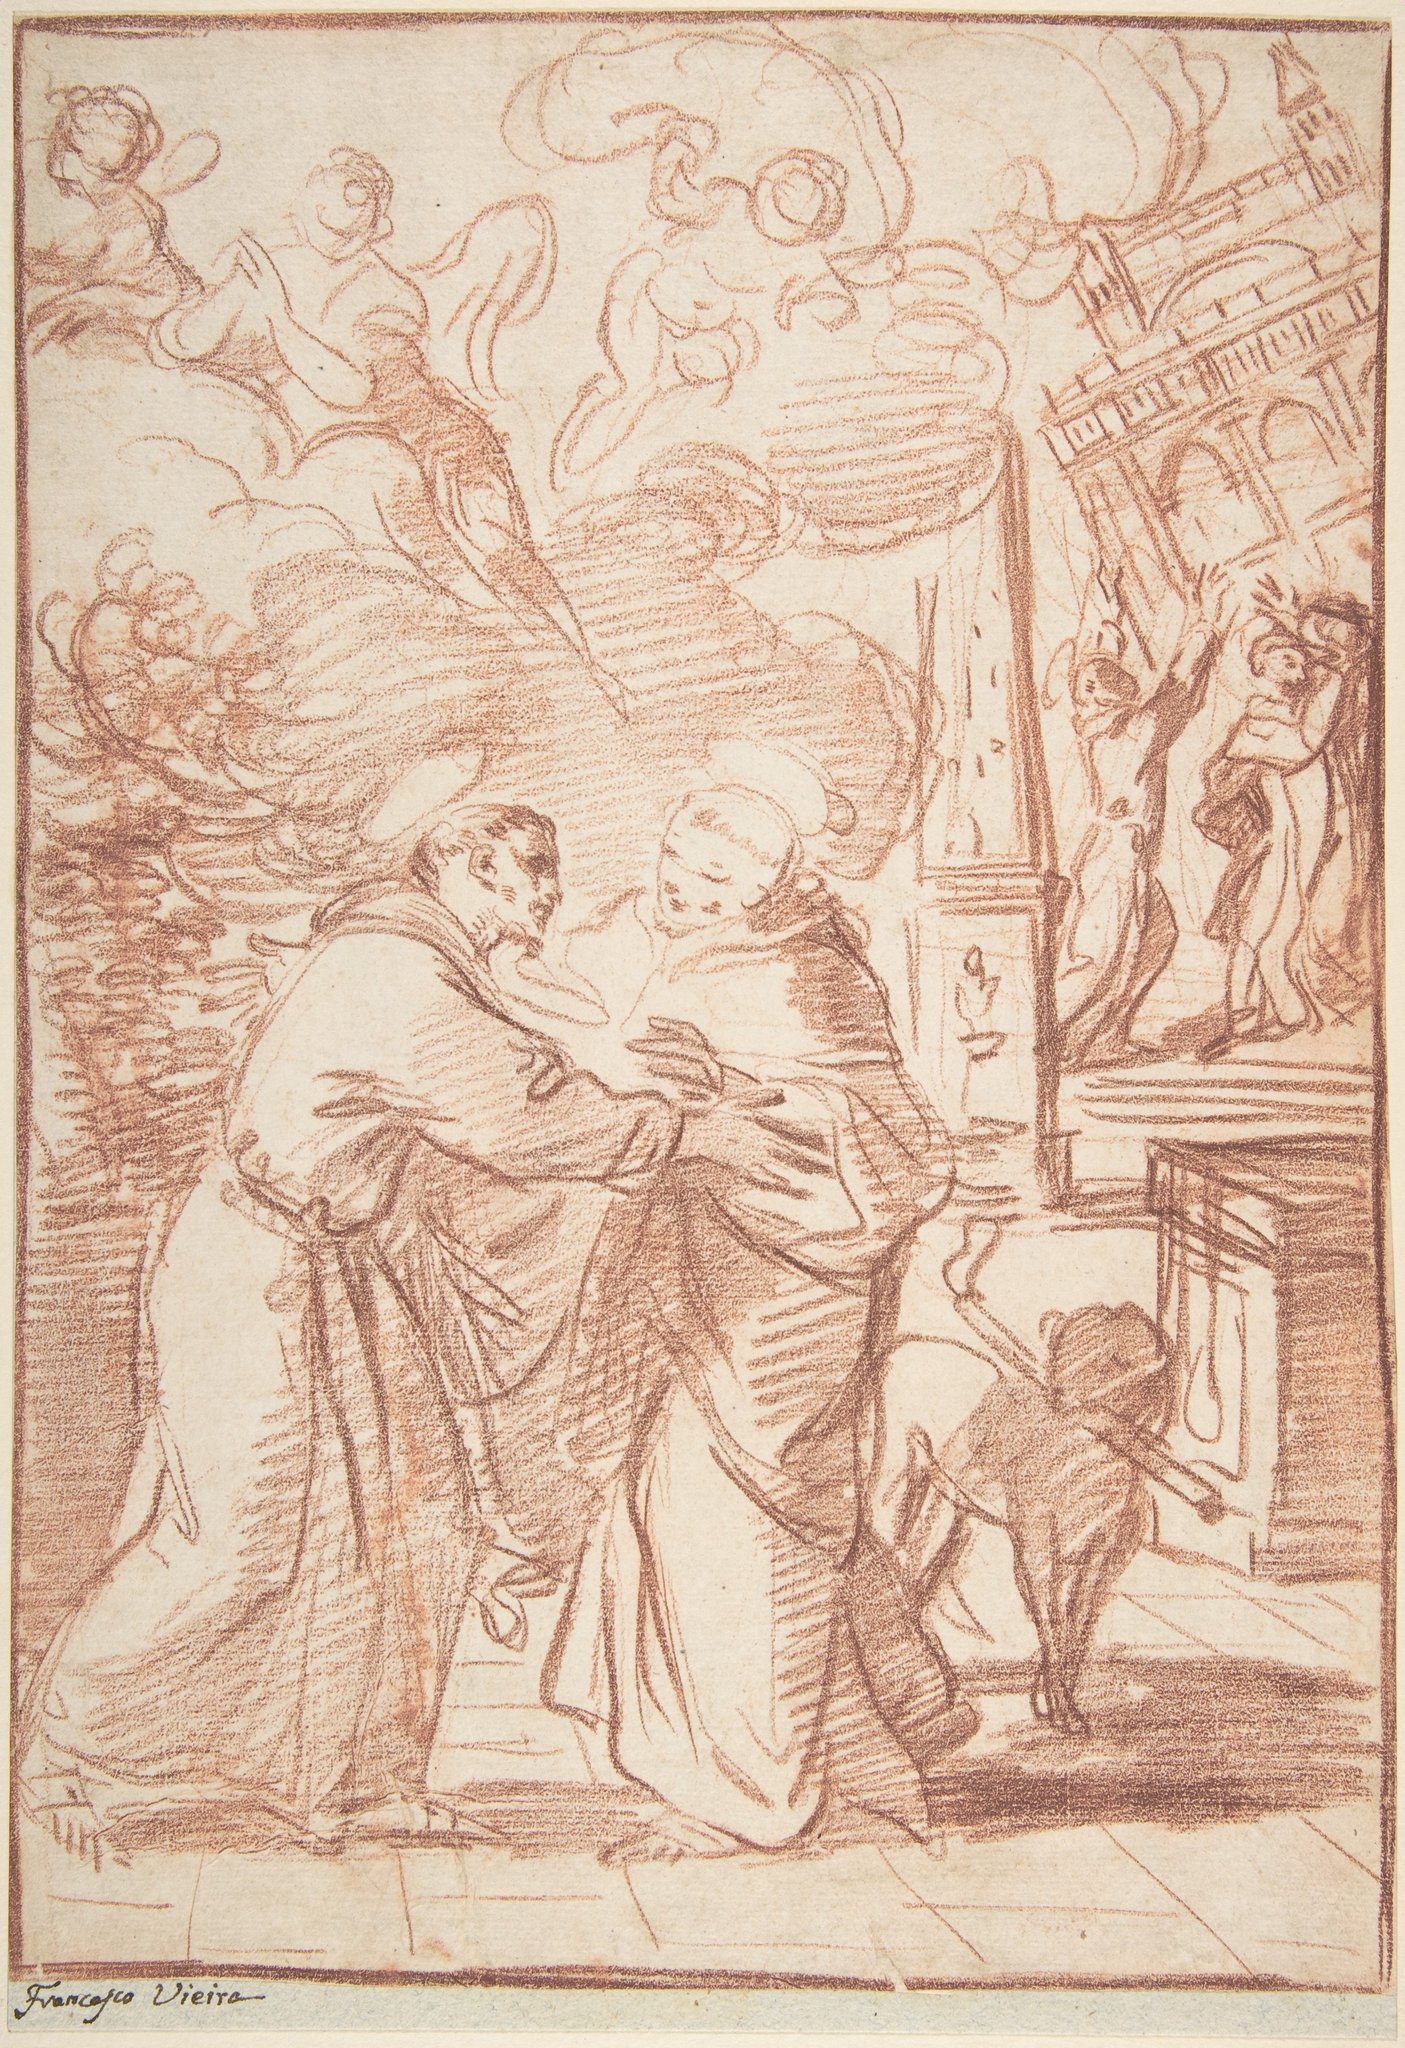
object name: drawing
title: Saint Francis Meeting Saint Dominic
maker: francisco vieira de mattos (il lusitano)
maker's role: artist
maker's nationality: portuguese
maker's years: 1699-1783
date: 1699-1783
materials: chalk, paper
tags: animals,men,saint francis,saints